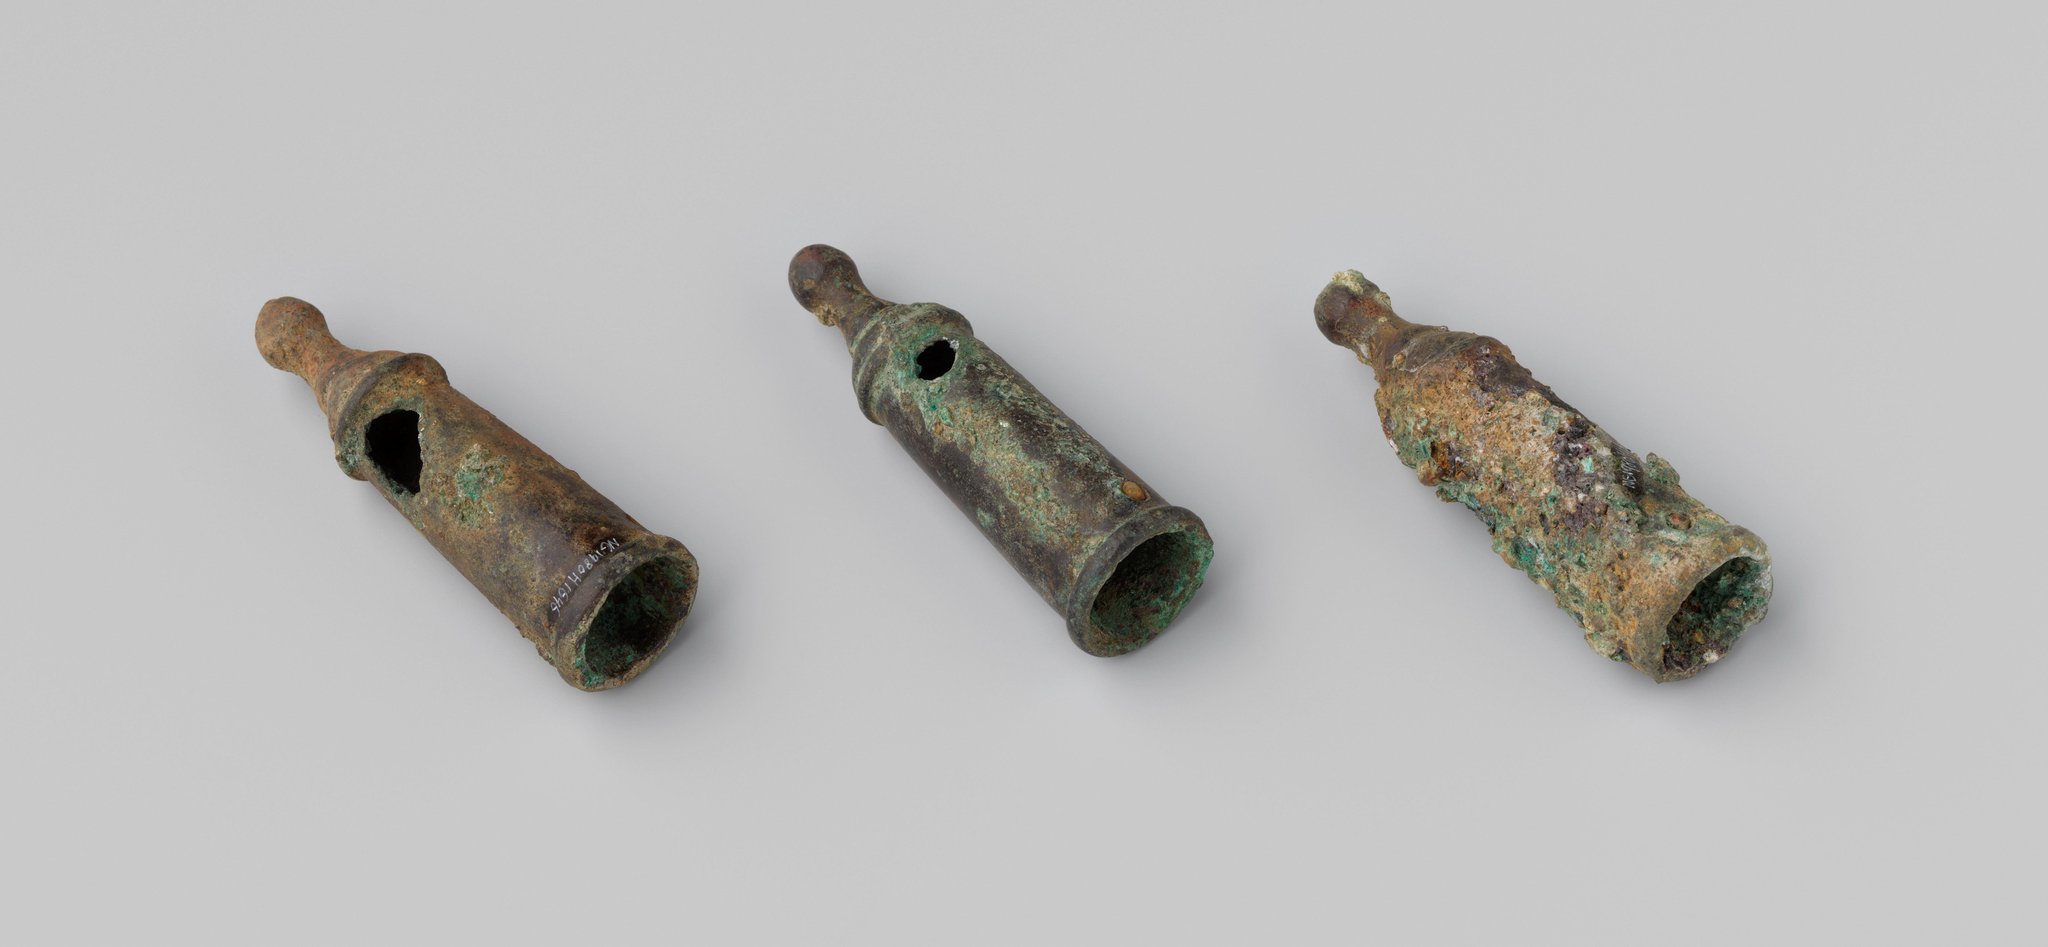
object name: clamp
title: Klemmen afkomstig uit het wrak van de Oost-Indiëvaarder Hollandia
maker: Anonymous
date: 1700-1743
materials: copper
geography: netherlands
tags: verenigde oostindische compagnie, hollandia (schip)